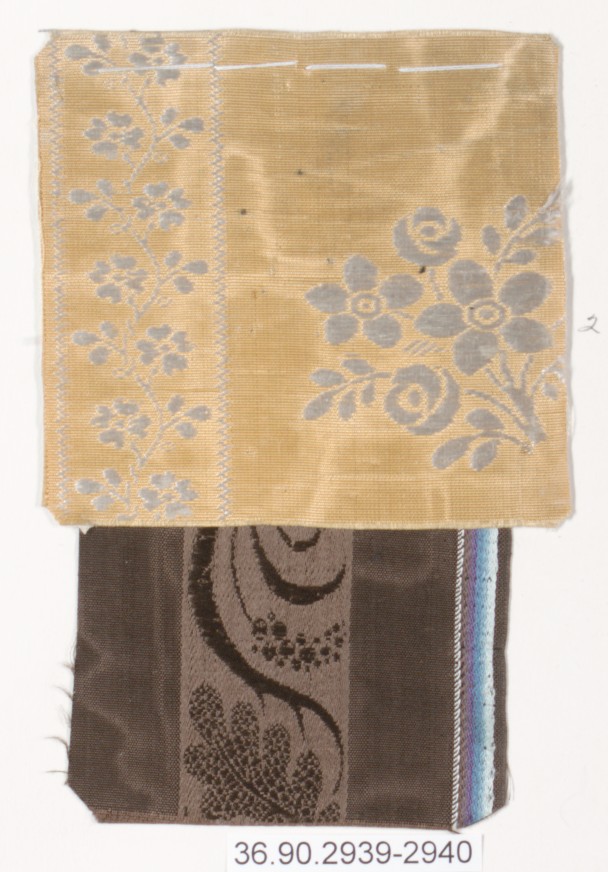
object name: piece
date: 1801-1900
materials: silk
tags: flowers,leaves